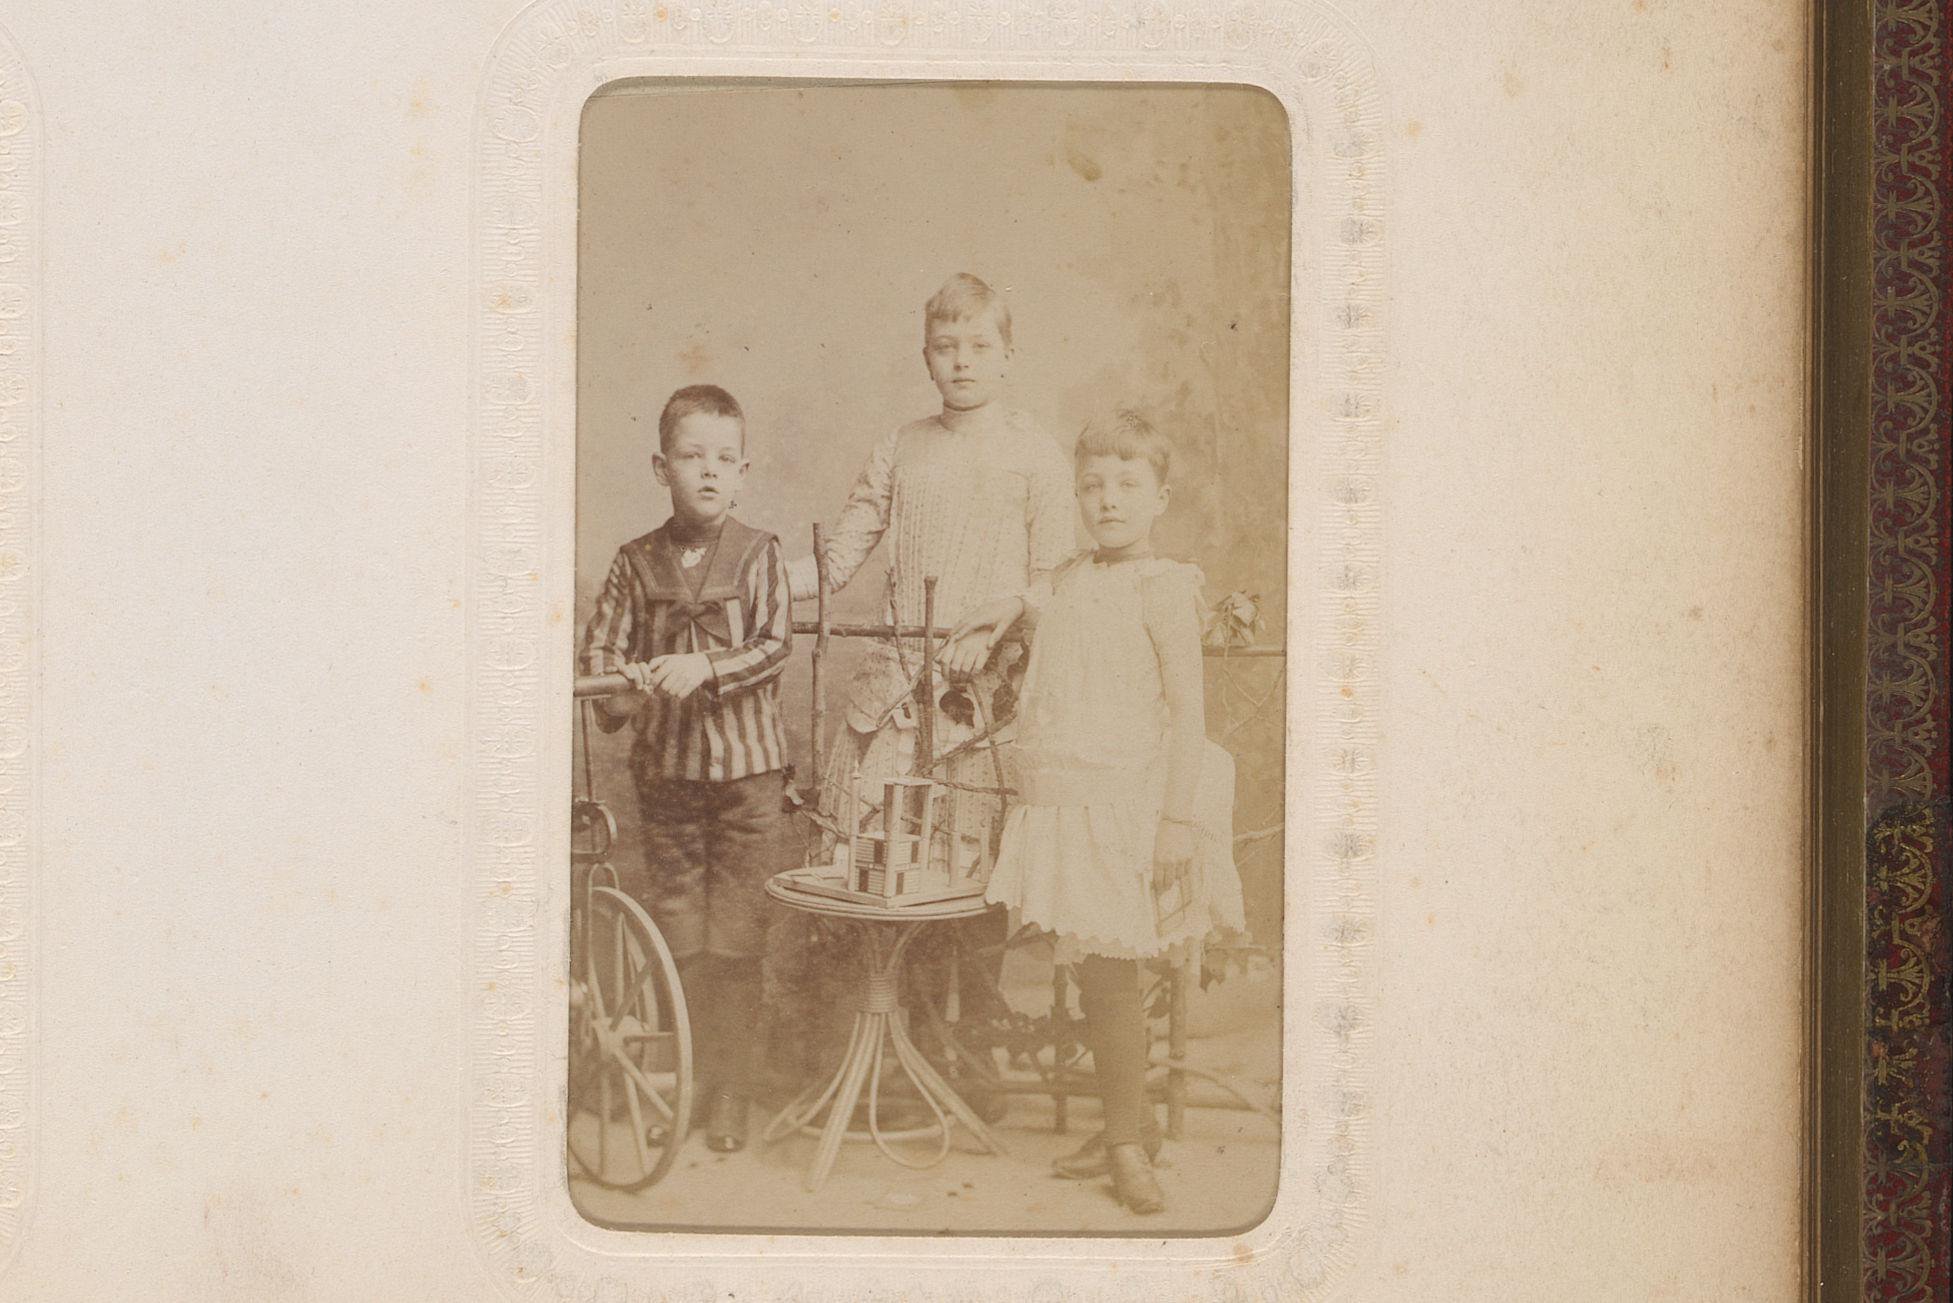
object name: carte de visite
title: Portret van een meisje, staand op een fauteuil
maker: Anonymous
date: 1860-1900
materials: cardboard, photographic support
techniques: albumen print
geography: netherlands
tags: historical persons - bb - woman, toddler (female), standing figure - aa - female human figure, chair